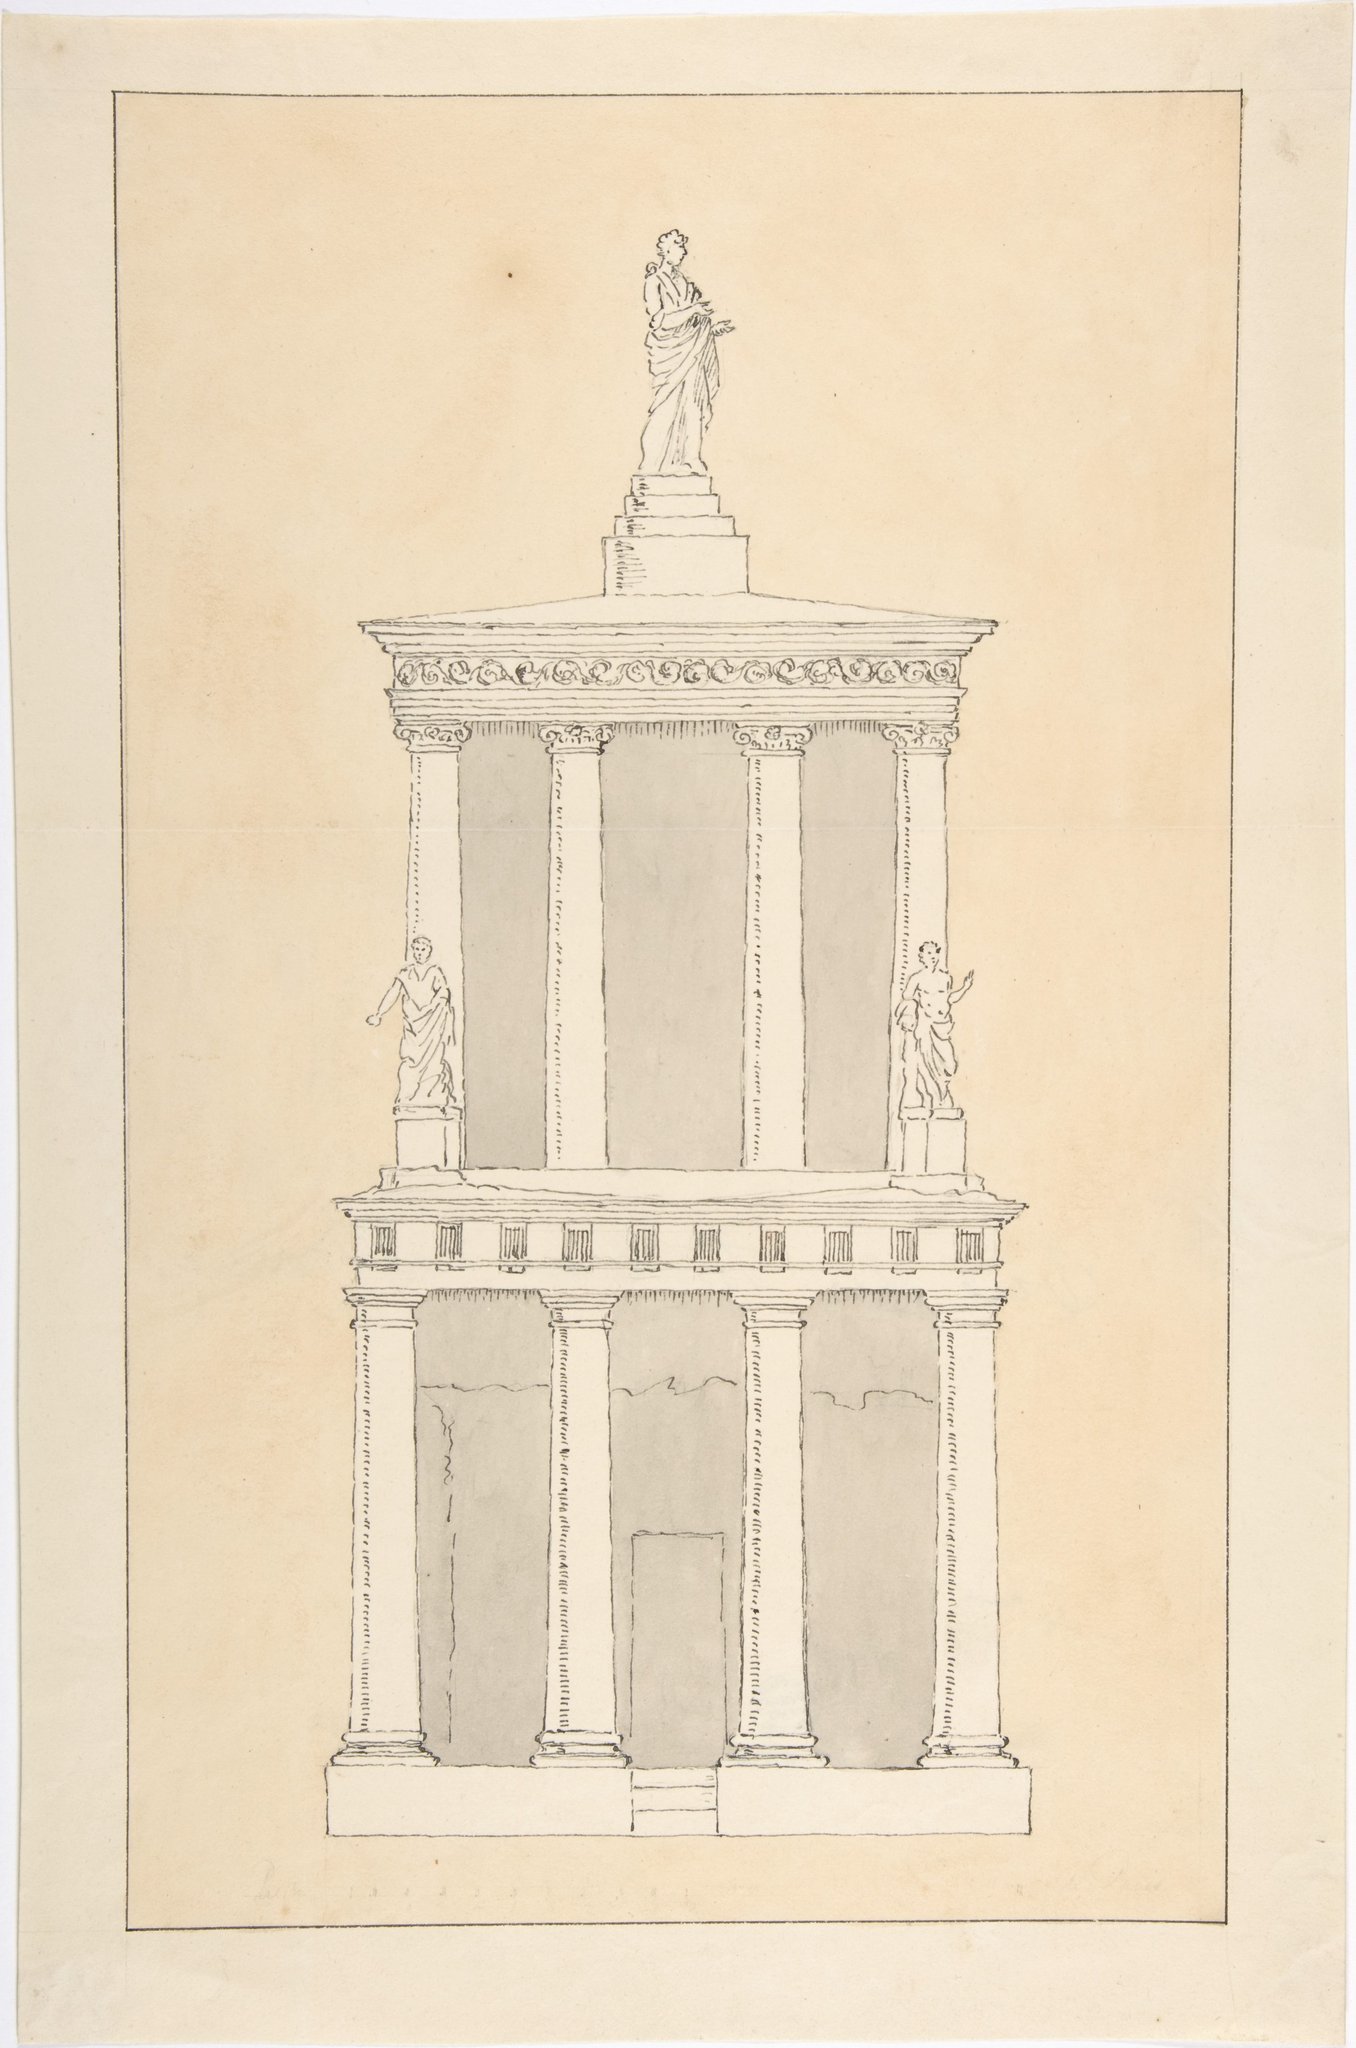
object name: drawing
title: Design for Tomb of Mamier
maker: anonymous, french, 18th century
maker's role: artist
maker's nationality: french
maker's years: 1700-1800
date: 1701-1800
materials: graphite, ink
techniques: brush, pen, wash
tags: architecture,tombs